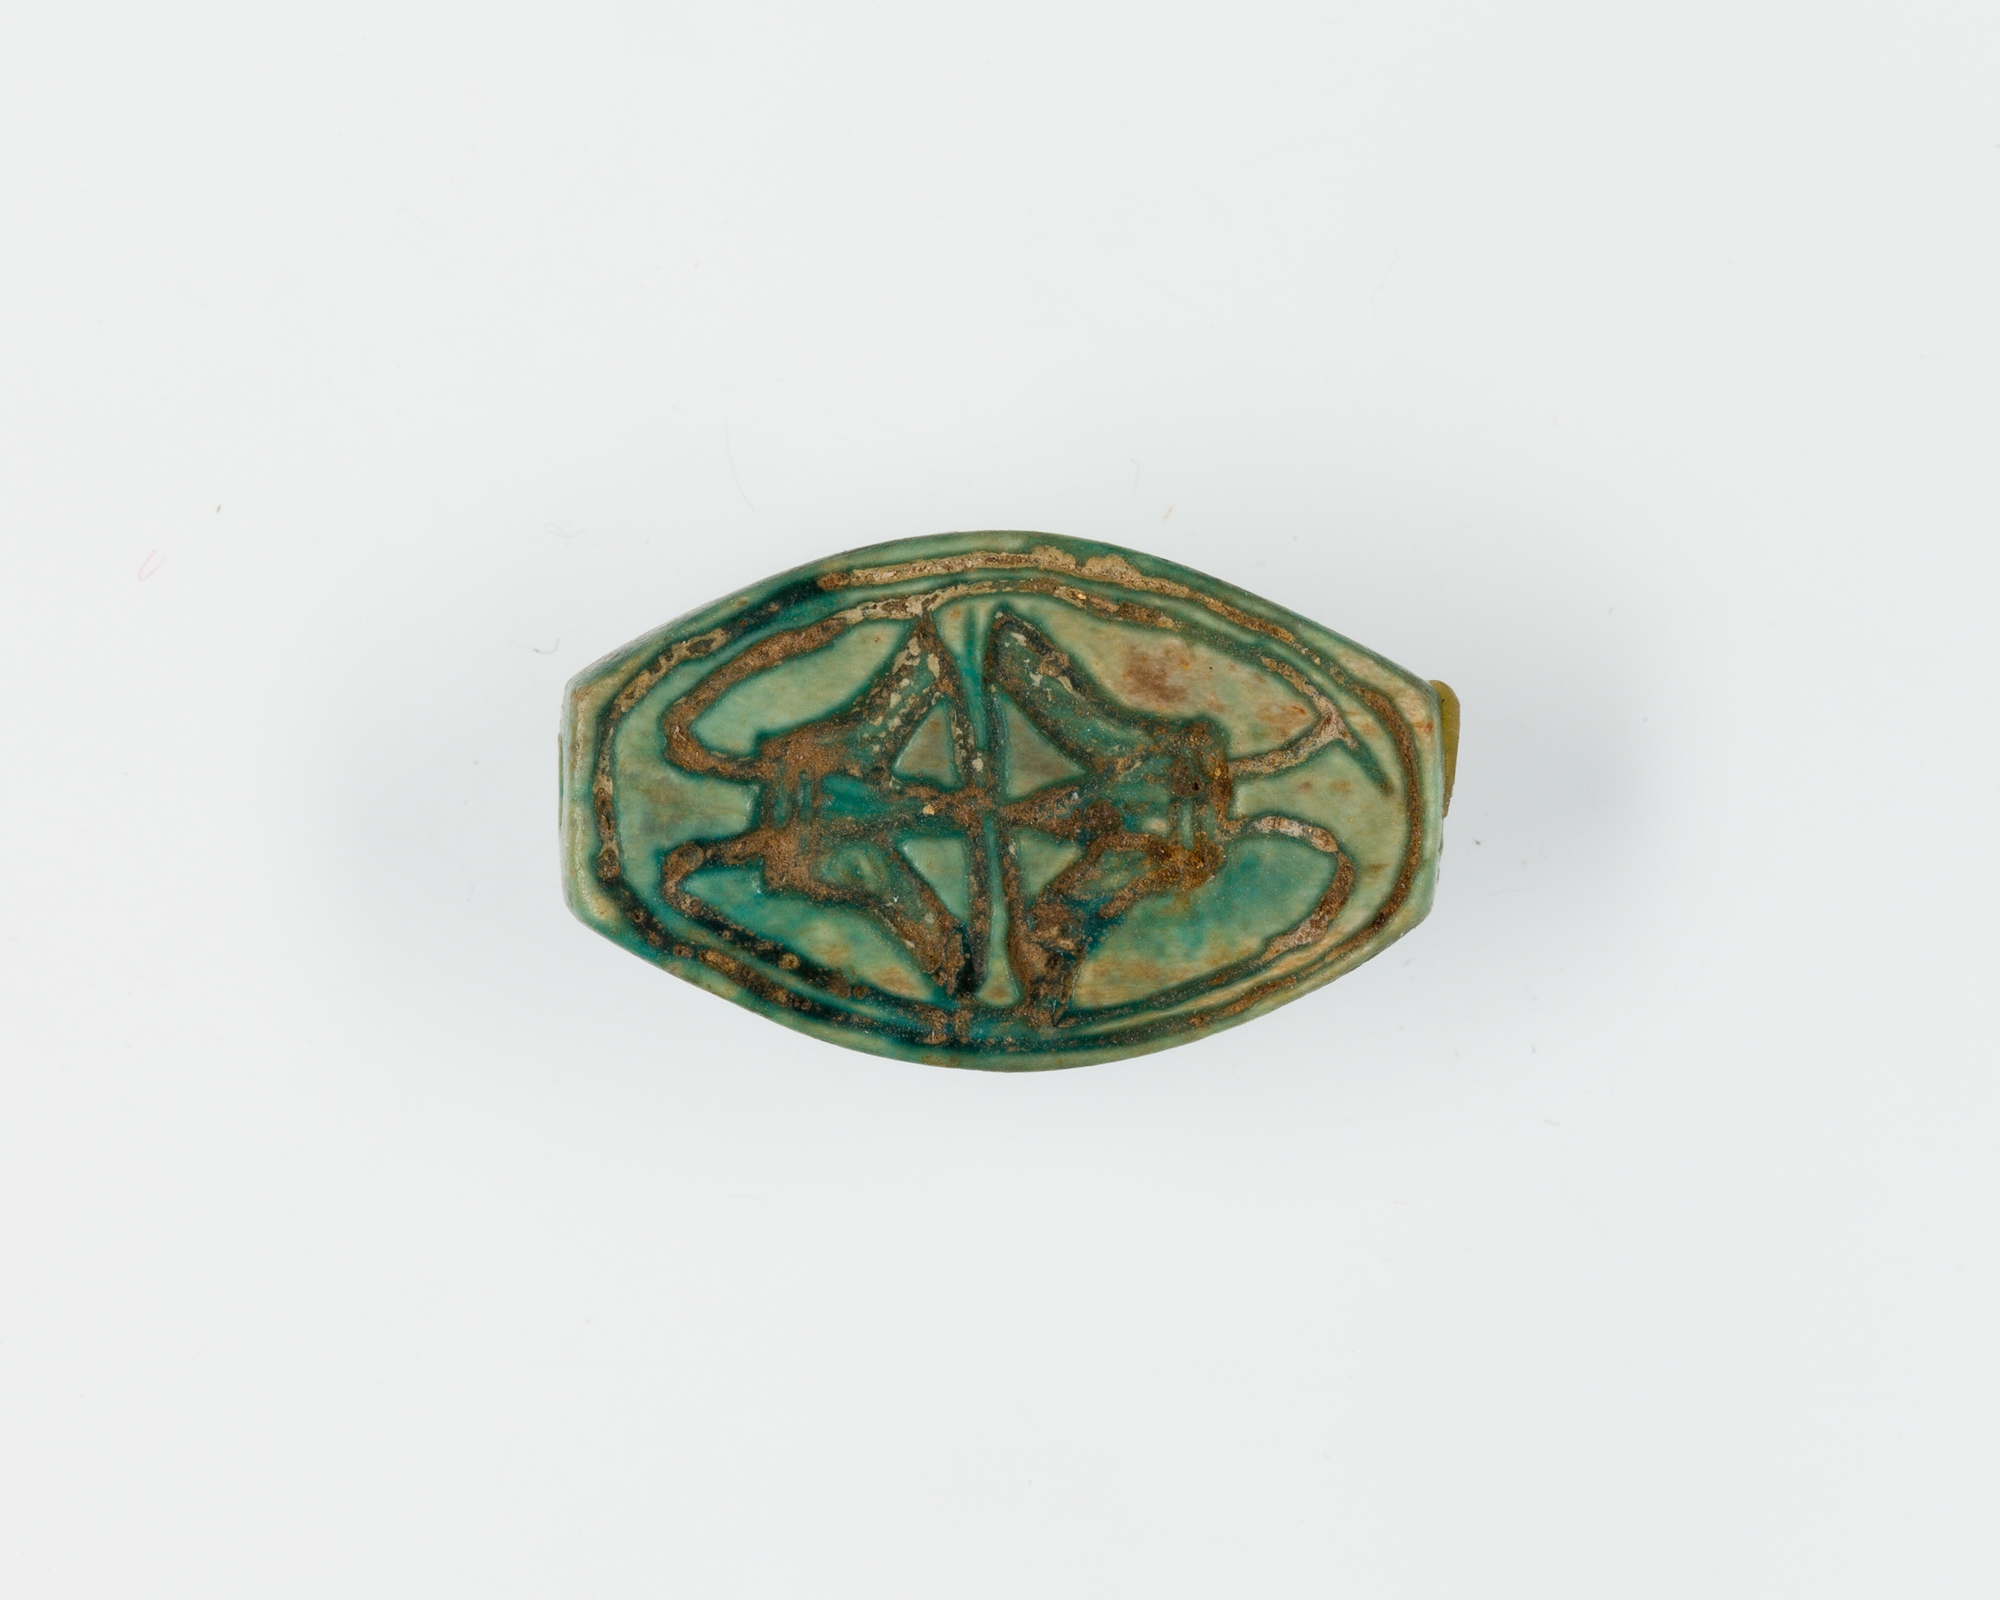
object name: scaraboid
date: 1492-1479 BCE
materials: faience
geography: egypt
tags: scarabs